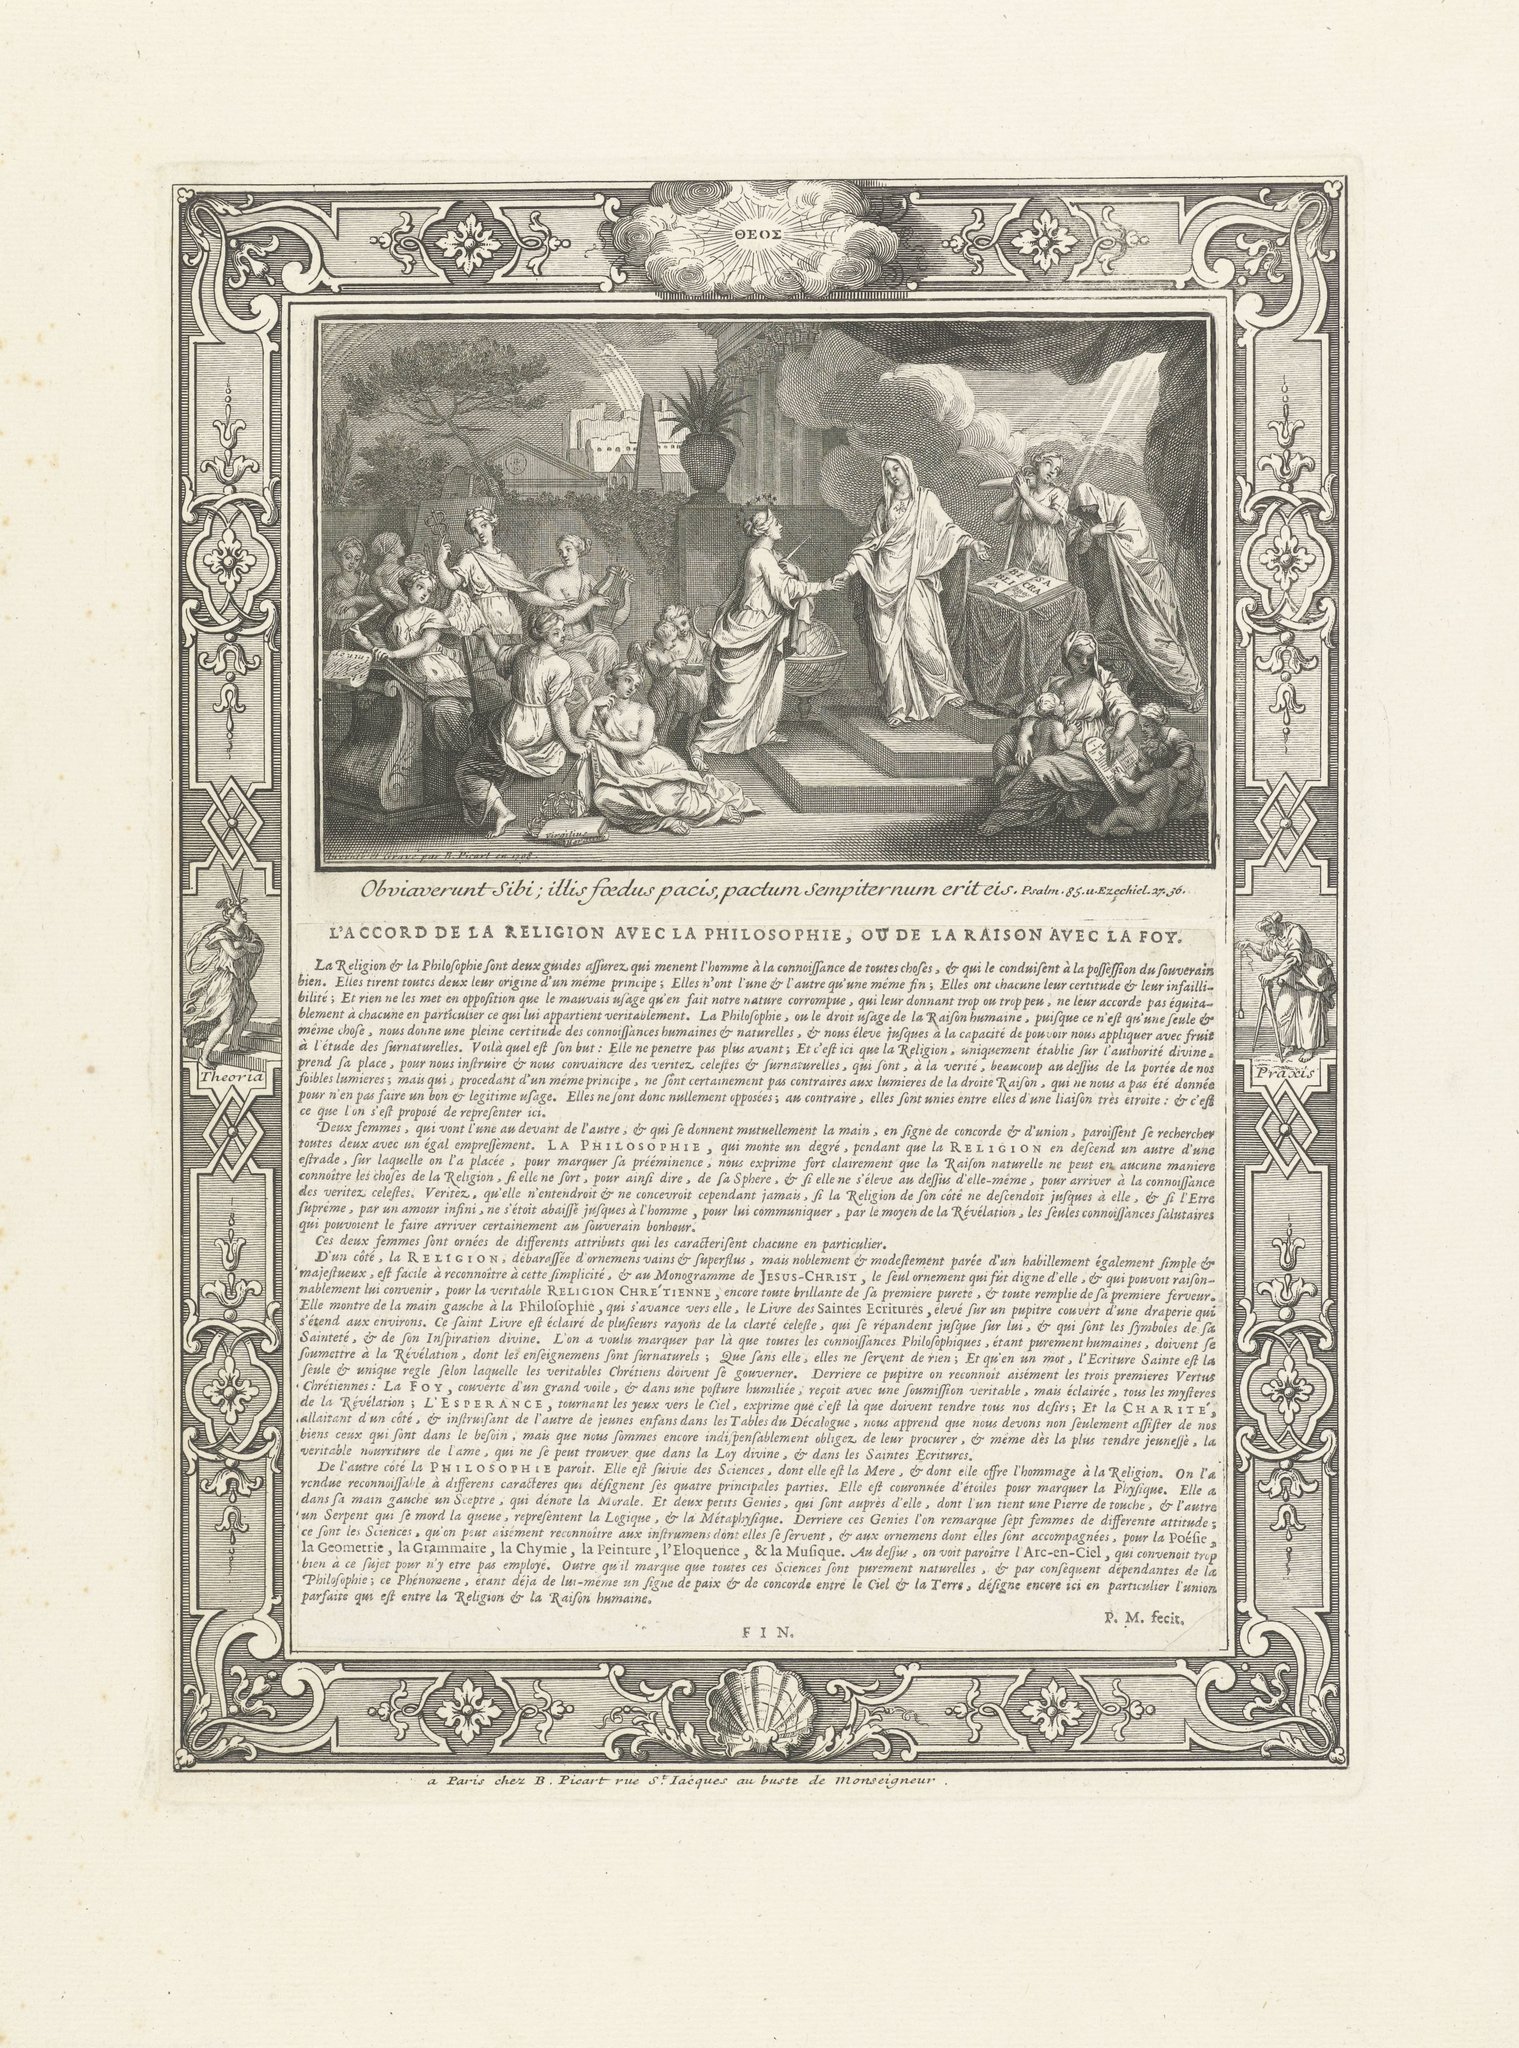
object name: promotieprent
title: Allegorische voorstelling van de overeenkomst tussen religie en filosofie, of het geloof en de rede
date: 1708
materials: paper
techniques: engraving, etching, letterpress printing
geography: paris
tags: greek script, charity, 'caritas'; 'carità' (ripa) ~ one of the three theological virtues, faith, 'fides'; 'fede', 'fede catholica', 'fede christiana', 'fede christiana catholica' (ripa) ~ one of the three theological virtues, hope, 'spes'; 'speranza divina e certa' (ripa) ~ one of the three theological virtues, practice; 'prattica' (ripa), reason; 'ragione' (ripa) (+ symbolical representation of concept), the liberal arts together with other disciplines, 'philosophia'; 'filosofia' (ripa), allegorical and symbolical representations ~ the church and religion, theory; 'theoria' (ripa)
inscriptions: collector's mark: Lugt 2228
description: Prent met een allegorische voorstelling die is verschenen voor een these filosofie van een onbekende persoon. De gepersonifieerde Filosofie, met een krans van sterren boven het hoofd, schudt de hand van Religie, die op de bijbel wijst. Achter hen staan Hoop (Spes) en Geloof (Fides). Rechts op de voorgrond Liefde (Caritas) die kinderen wijst op de tafelen der wet. Links de vrouwlijke personificaties van de zeven vrije kunsten. In de marge een Bijbelcitaat in het Latijn. Onder de voorstelling een tekst in het Frans. Het geheel is gedecoreerd met een ornamentele omlijsting waarin Theorie en Praktijk.